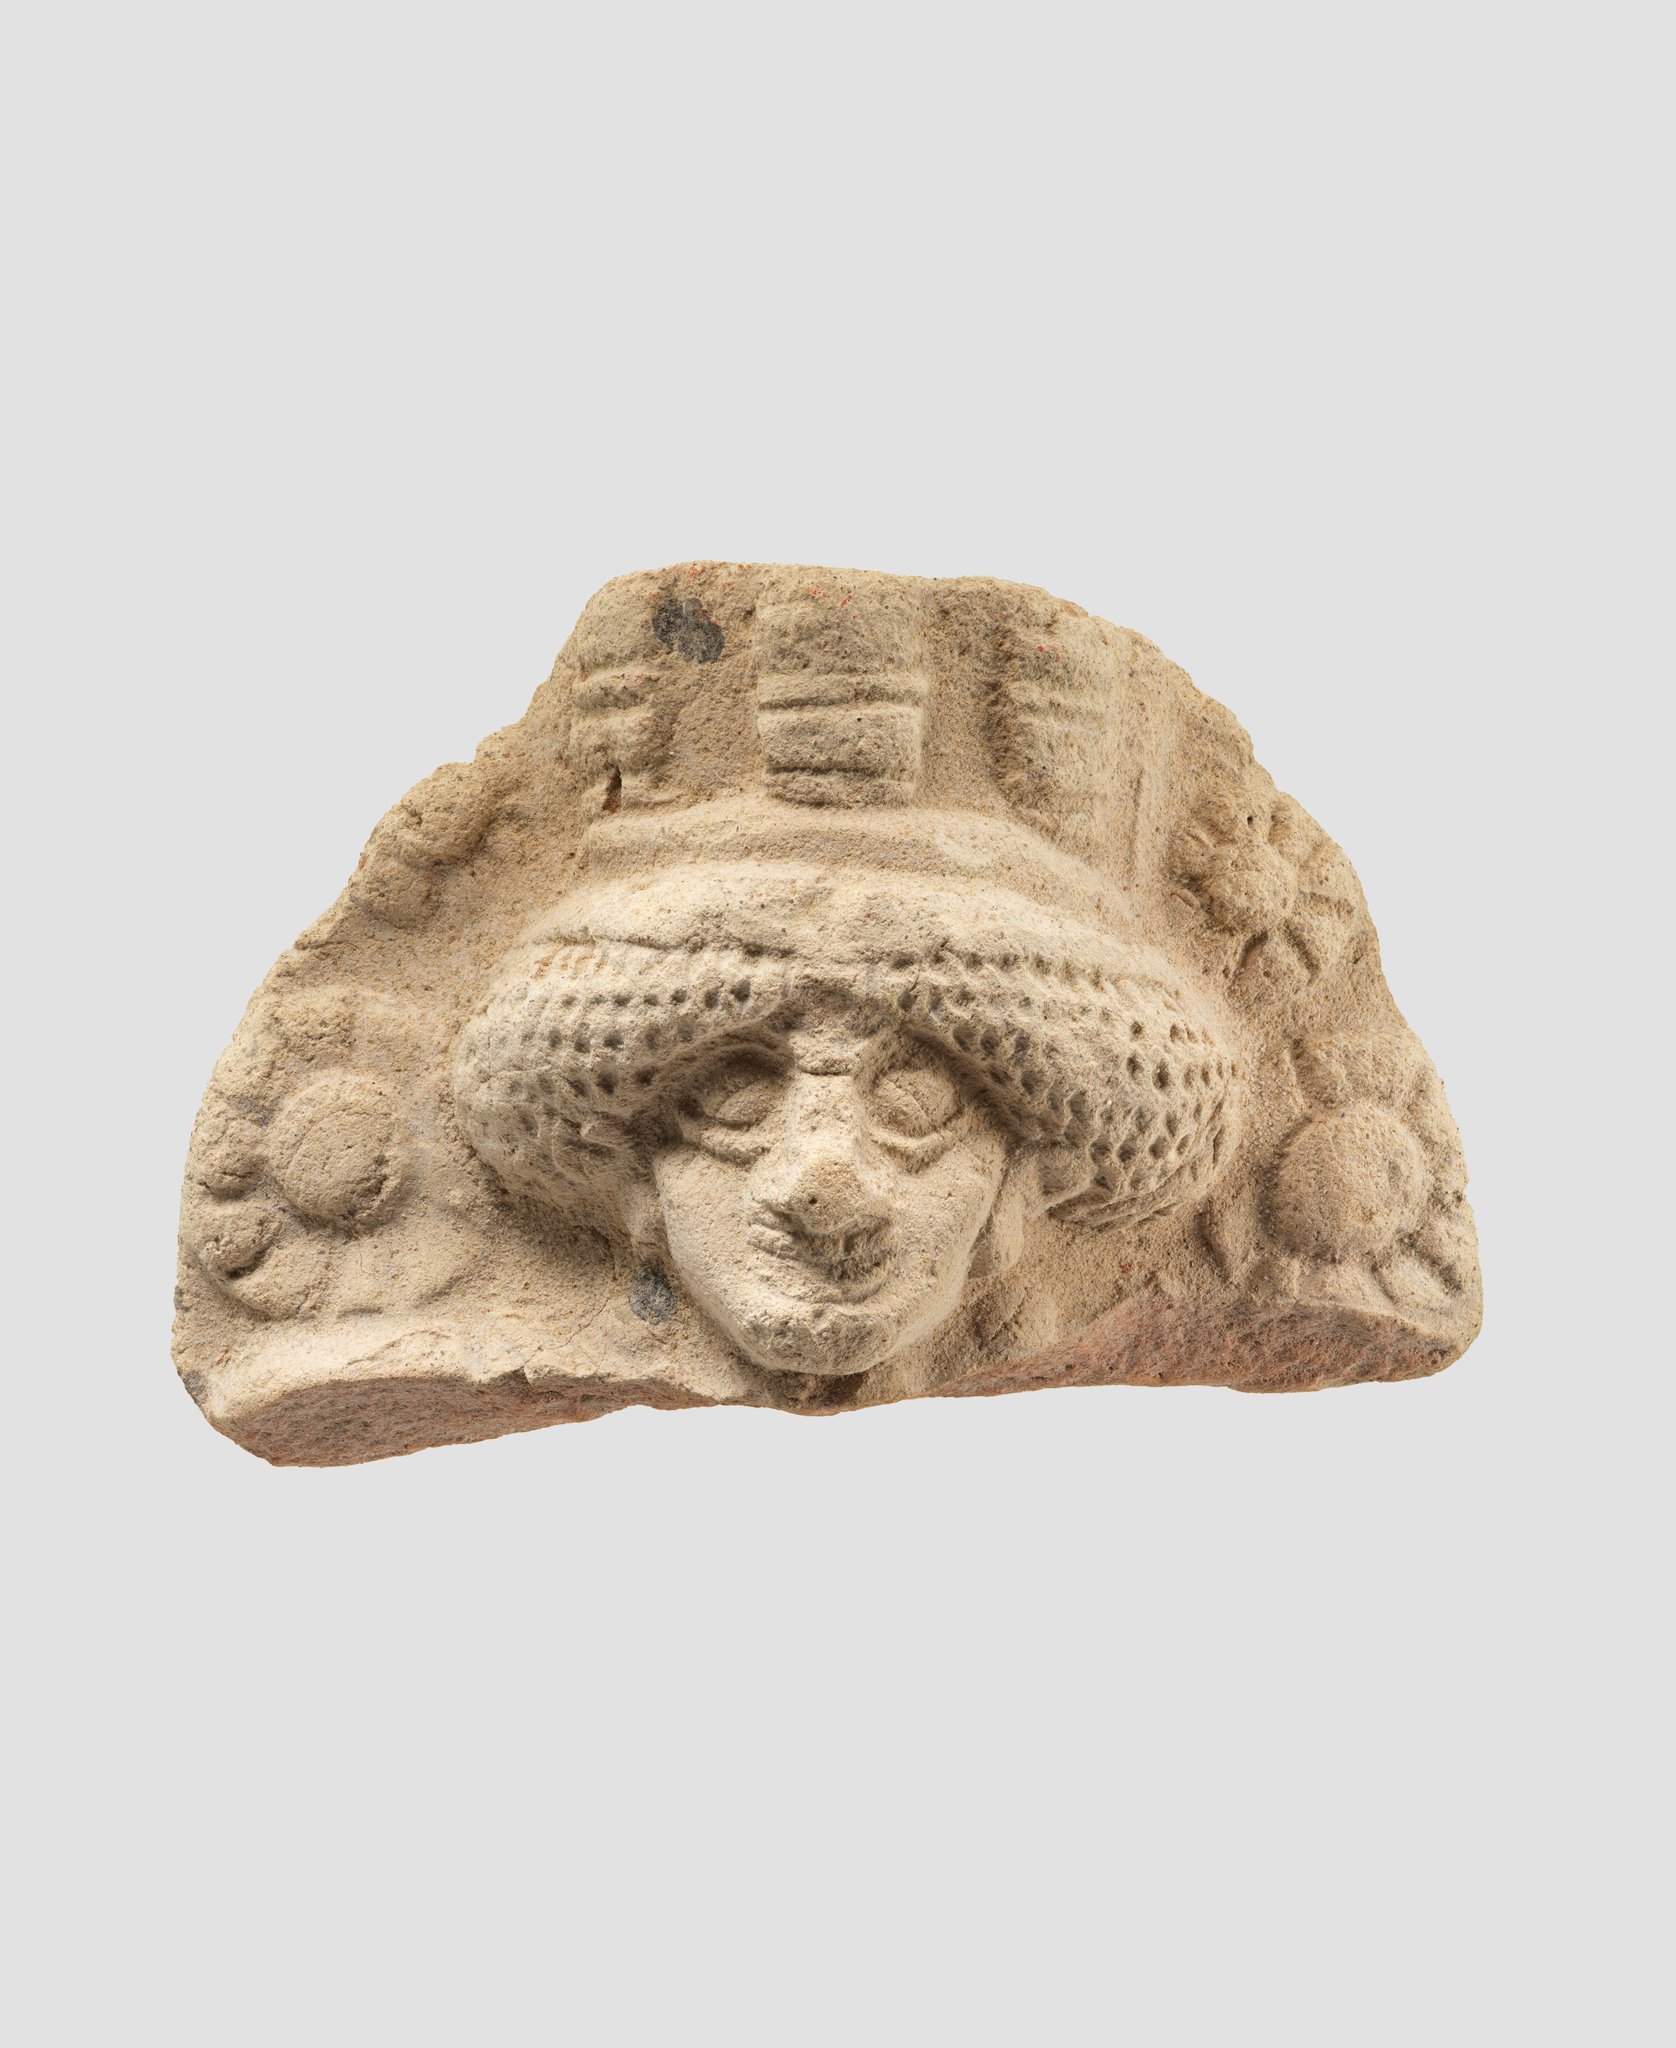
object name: relief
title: Molded plaque: female head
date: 2100-1750 BCE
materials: ceramic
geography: southern mesopotamia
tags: heads,women